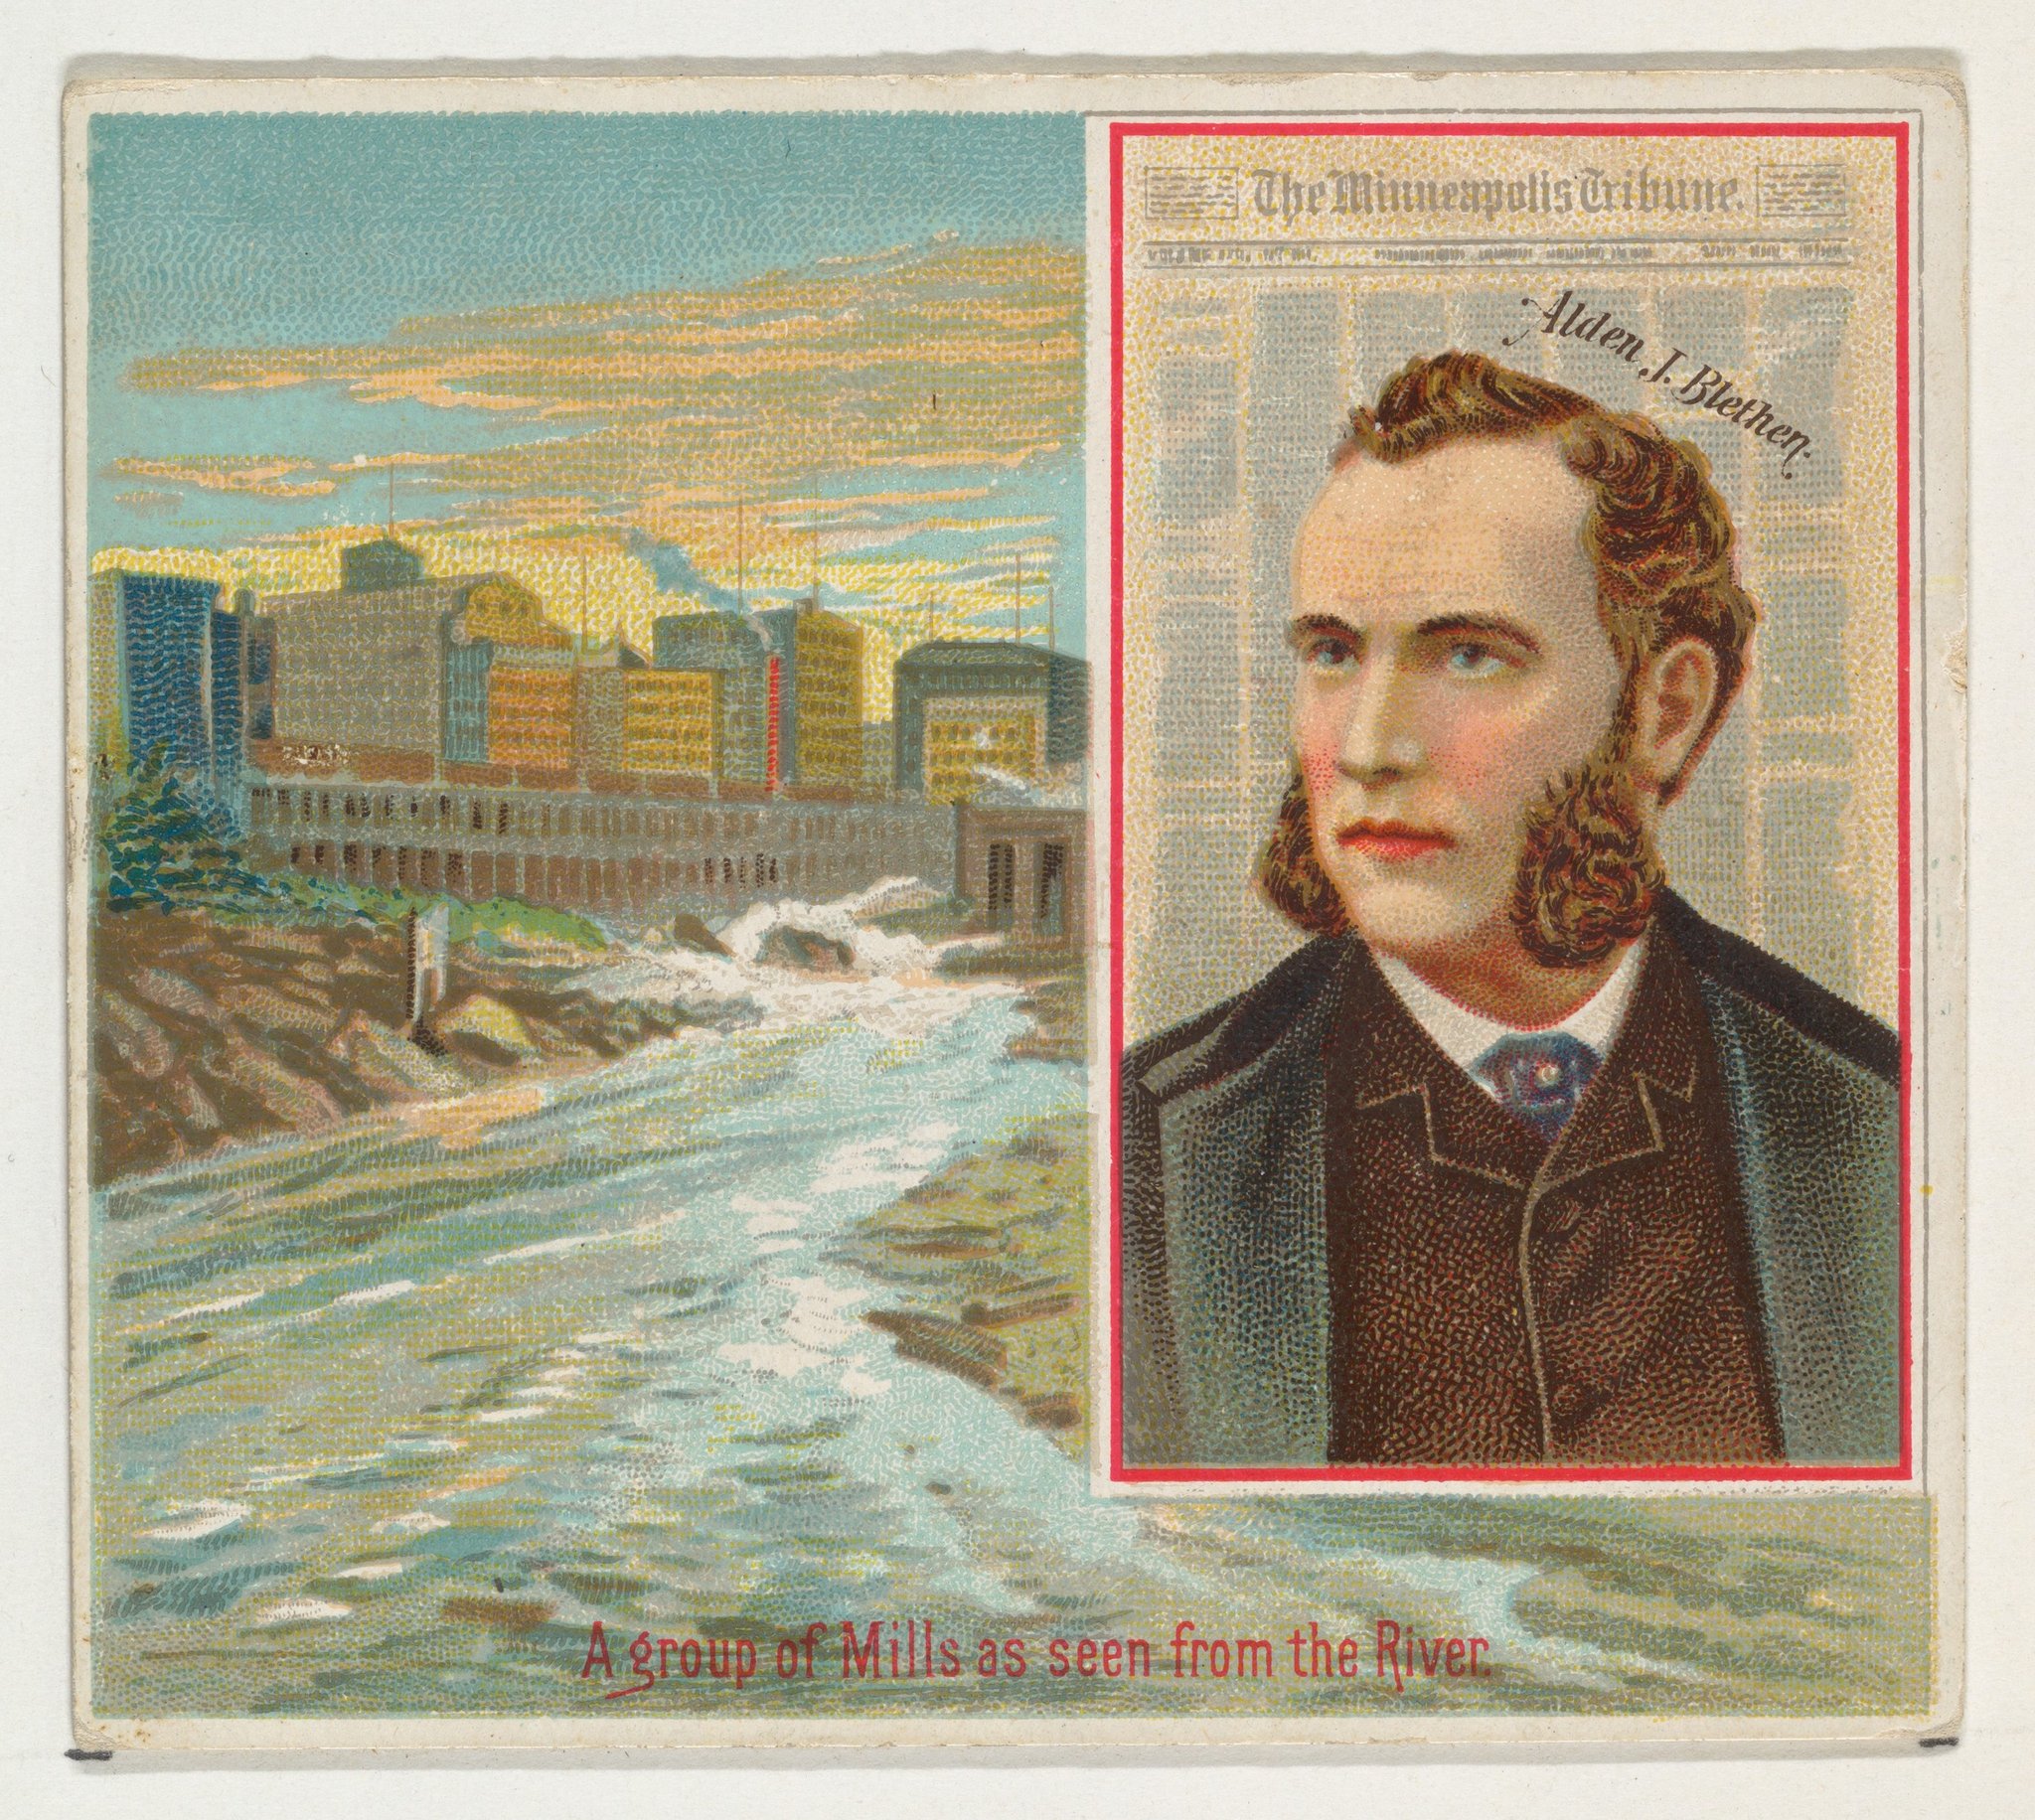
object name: print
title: Alden J. Blethen, The Minneapolis Tribune, from the American Editors series (N35) for Allen & Ginter Cigarettes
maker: allen & ginter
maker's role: publisher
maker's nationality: american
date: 1887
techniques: color lithograph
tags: men,rivers